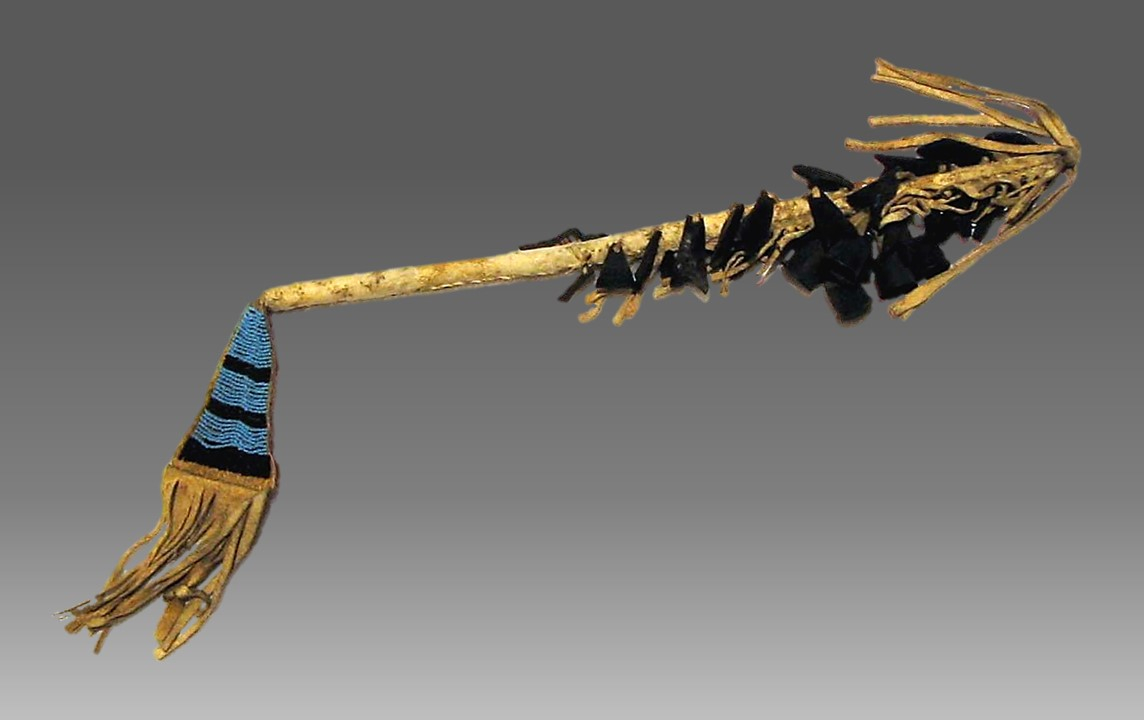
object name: rattle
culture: native american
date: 1801-1900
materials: horn, leather, wood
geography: united states